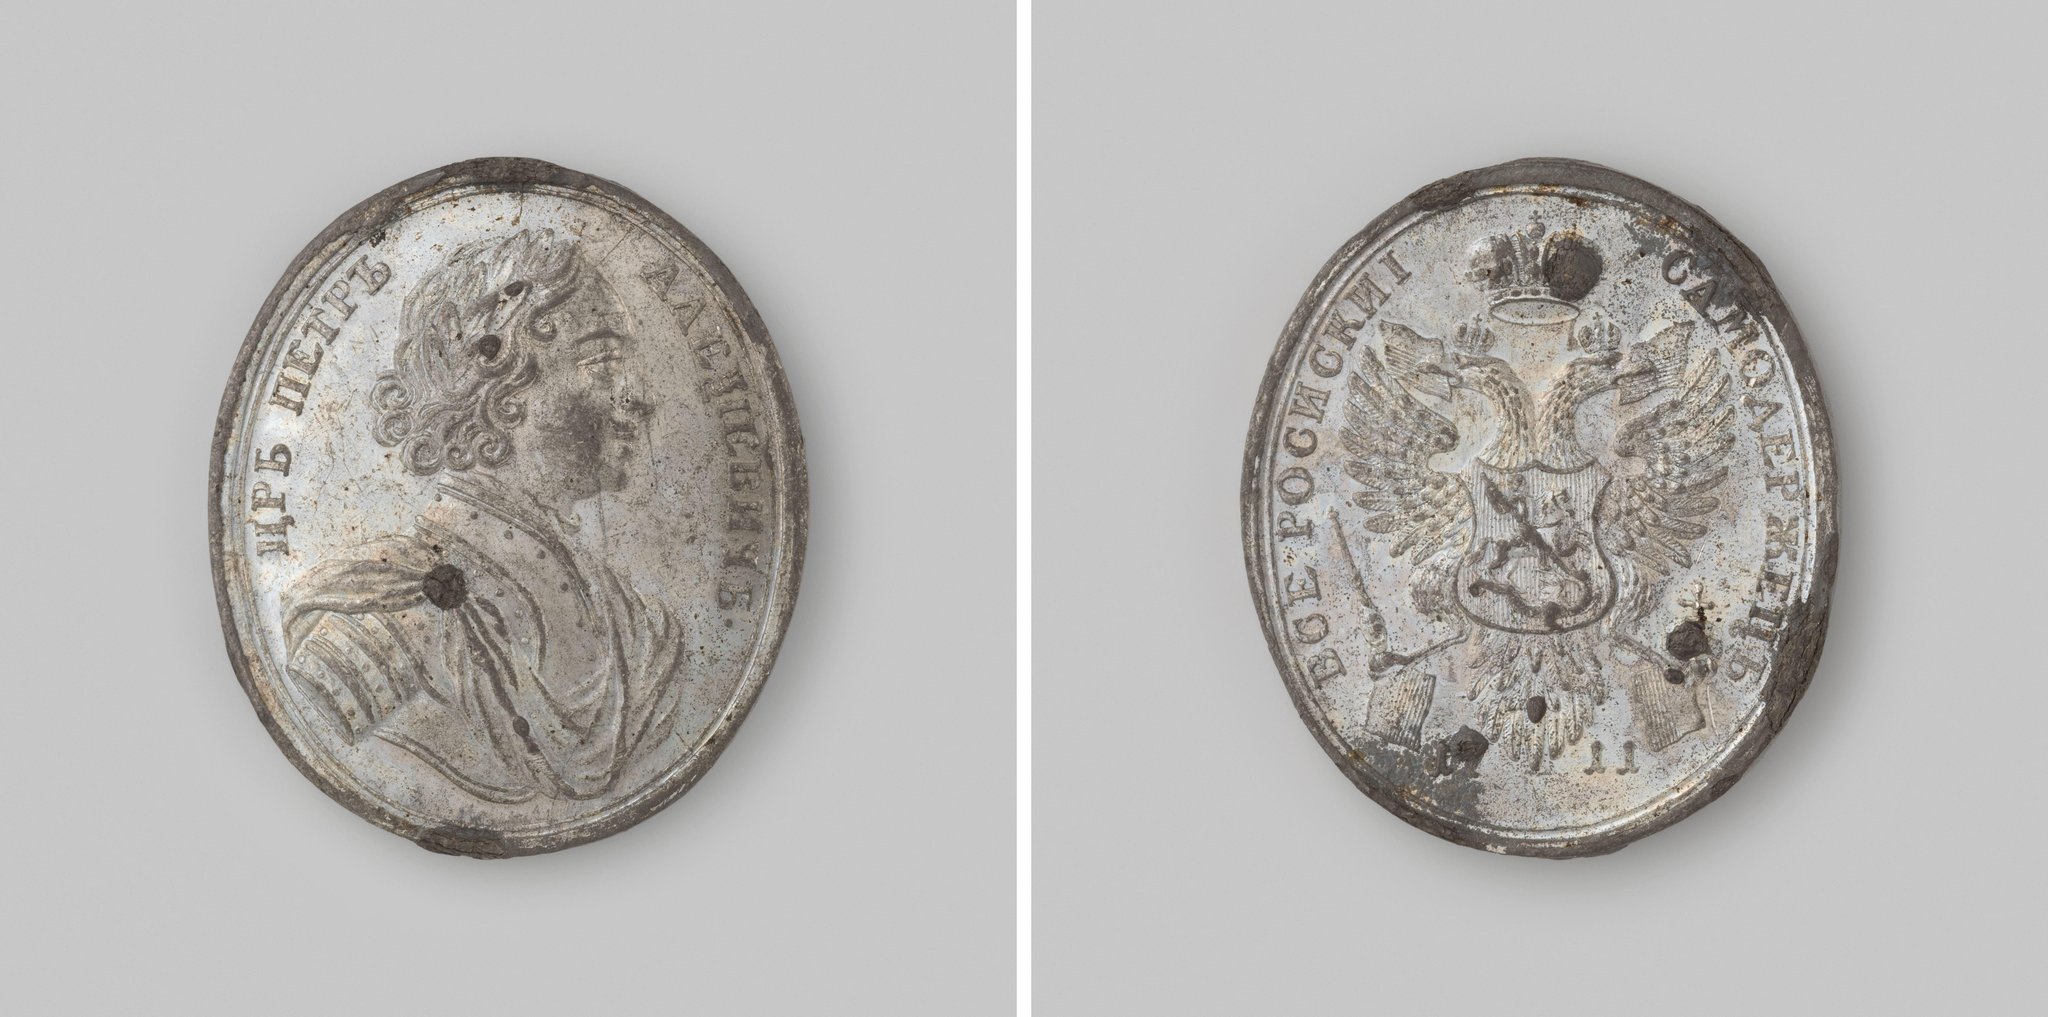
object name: history medal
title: Vlootbouw door Rusland op de vier zeëen 1711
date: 1711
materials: tin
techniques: striking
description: Ovalen tinnen penning, op de voorzijde het borstbeeld van Tsaar Peter de Grote naar rechts met omschrift, op de keerzijde de Russische adelaar met omschrift.